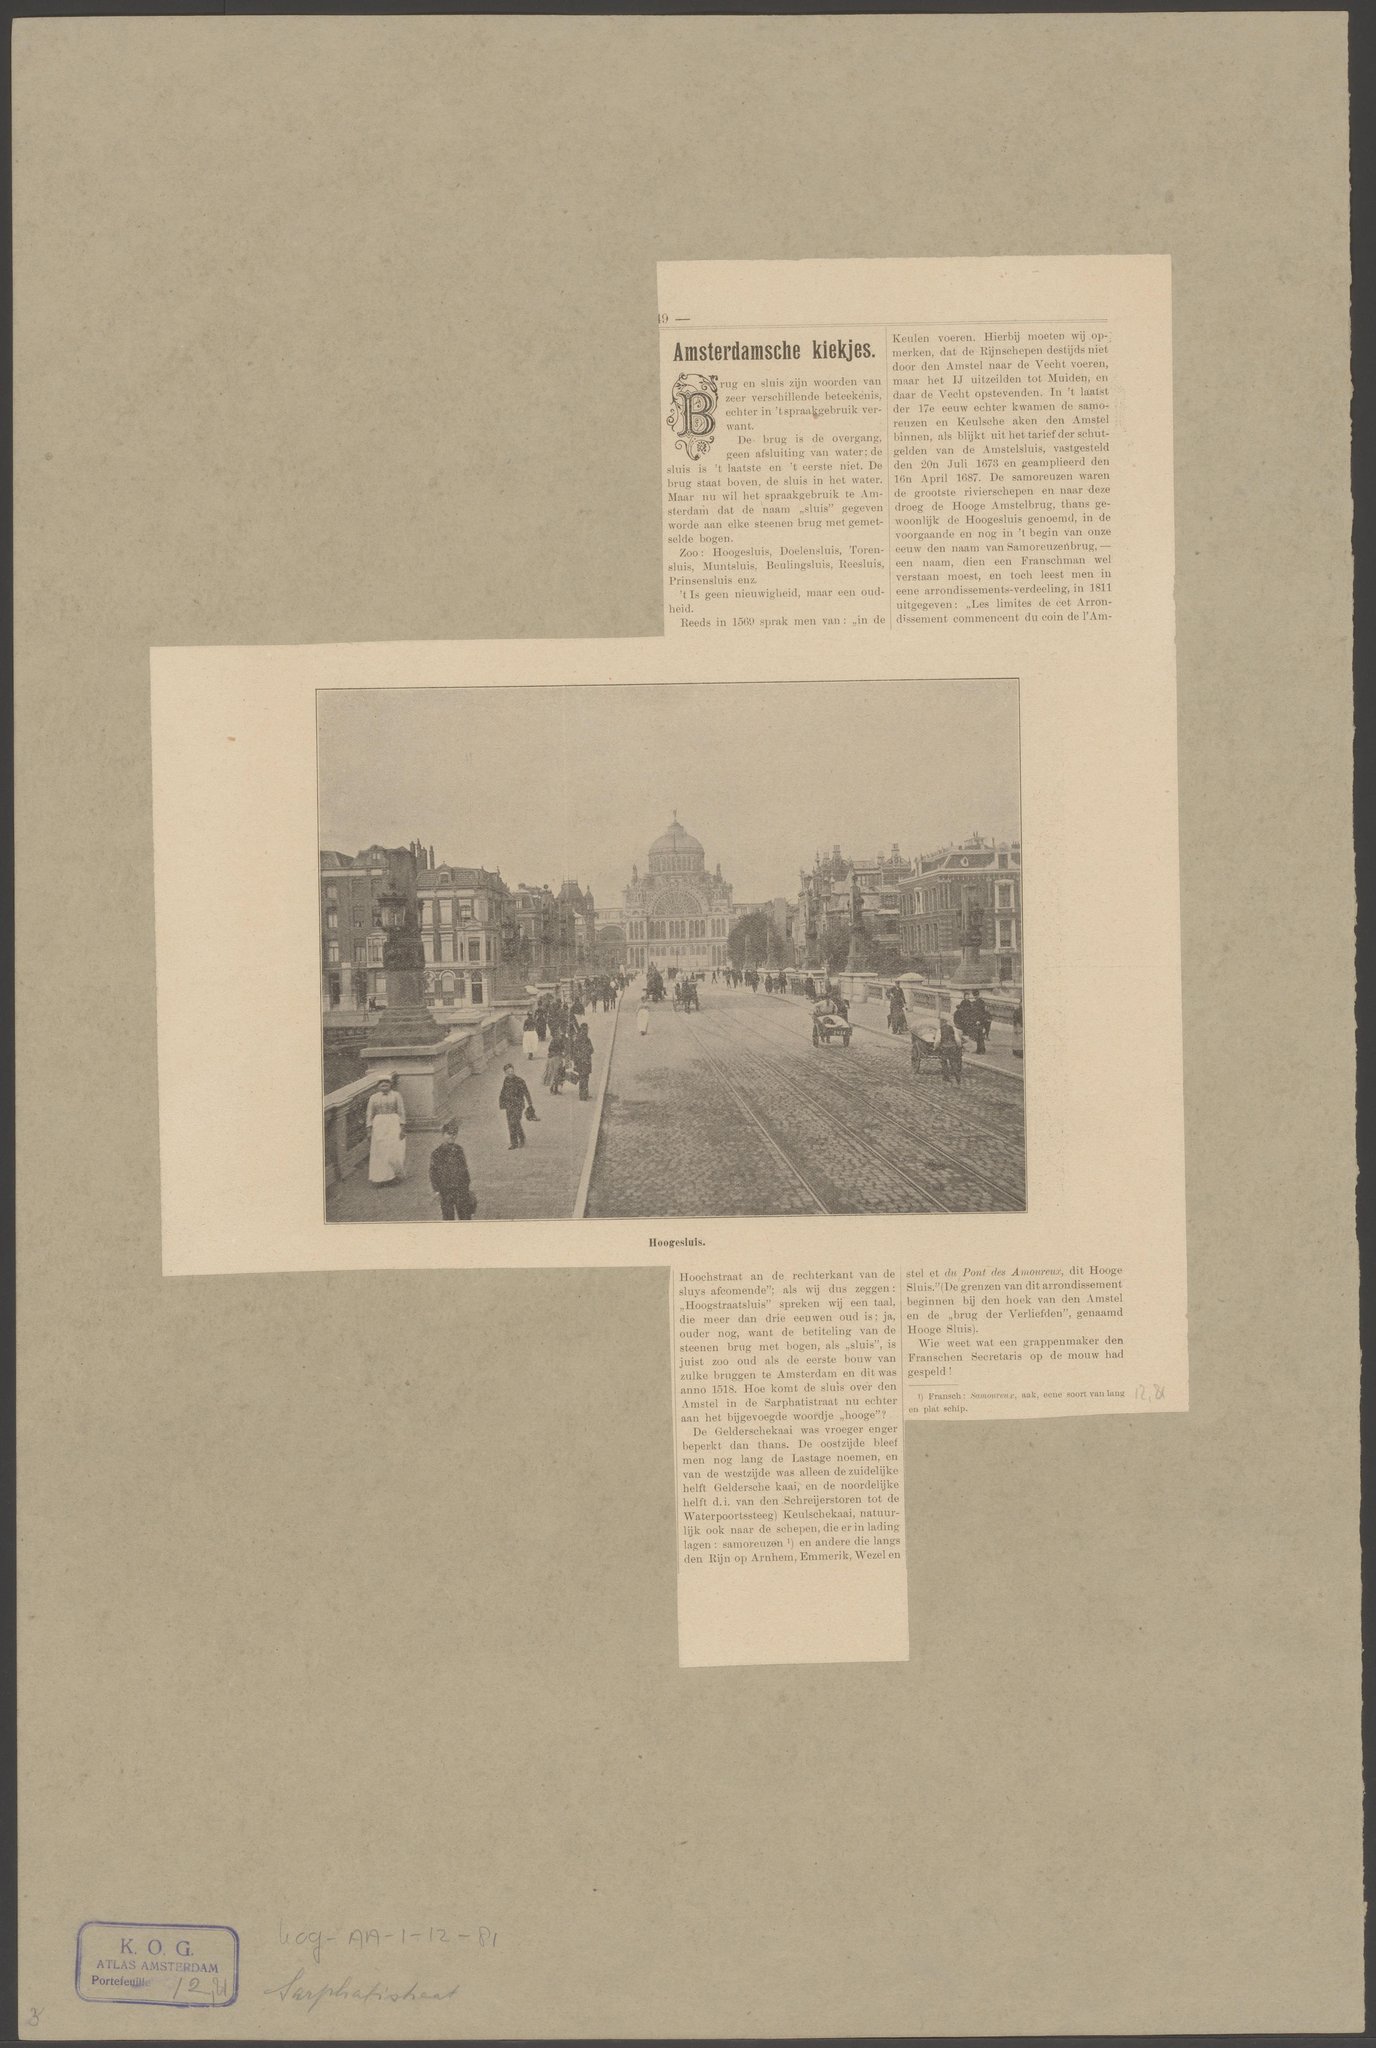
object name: photomechanical print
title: Gezicht op het Paleis voor Volksvlijt vanaf de Sarphatistraat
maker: Anonymous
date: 1882-1950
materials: paper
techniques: letterpress printing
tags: tramway, tram, city-view in general; 'veduta', permanent exhibition, museum, street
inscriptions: inscription: ‘Sarphatistraat’, collector's mark: ‘12,81’ Lugt 1641b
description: Onderwerpsrubriek binnen de Atlas Amsterdam: Sarphatistraat, Schans.